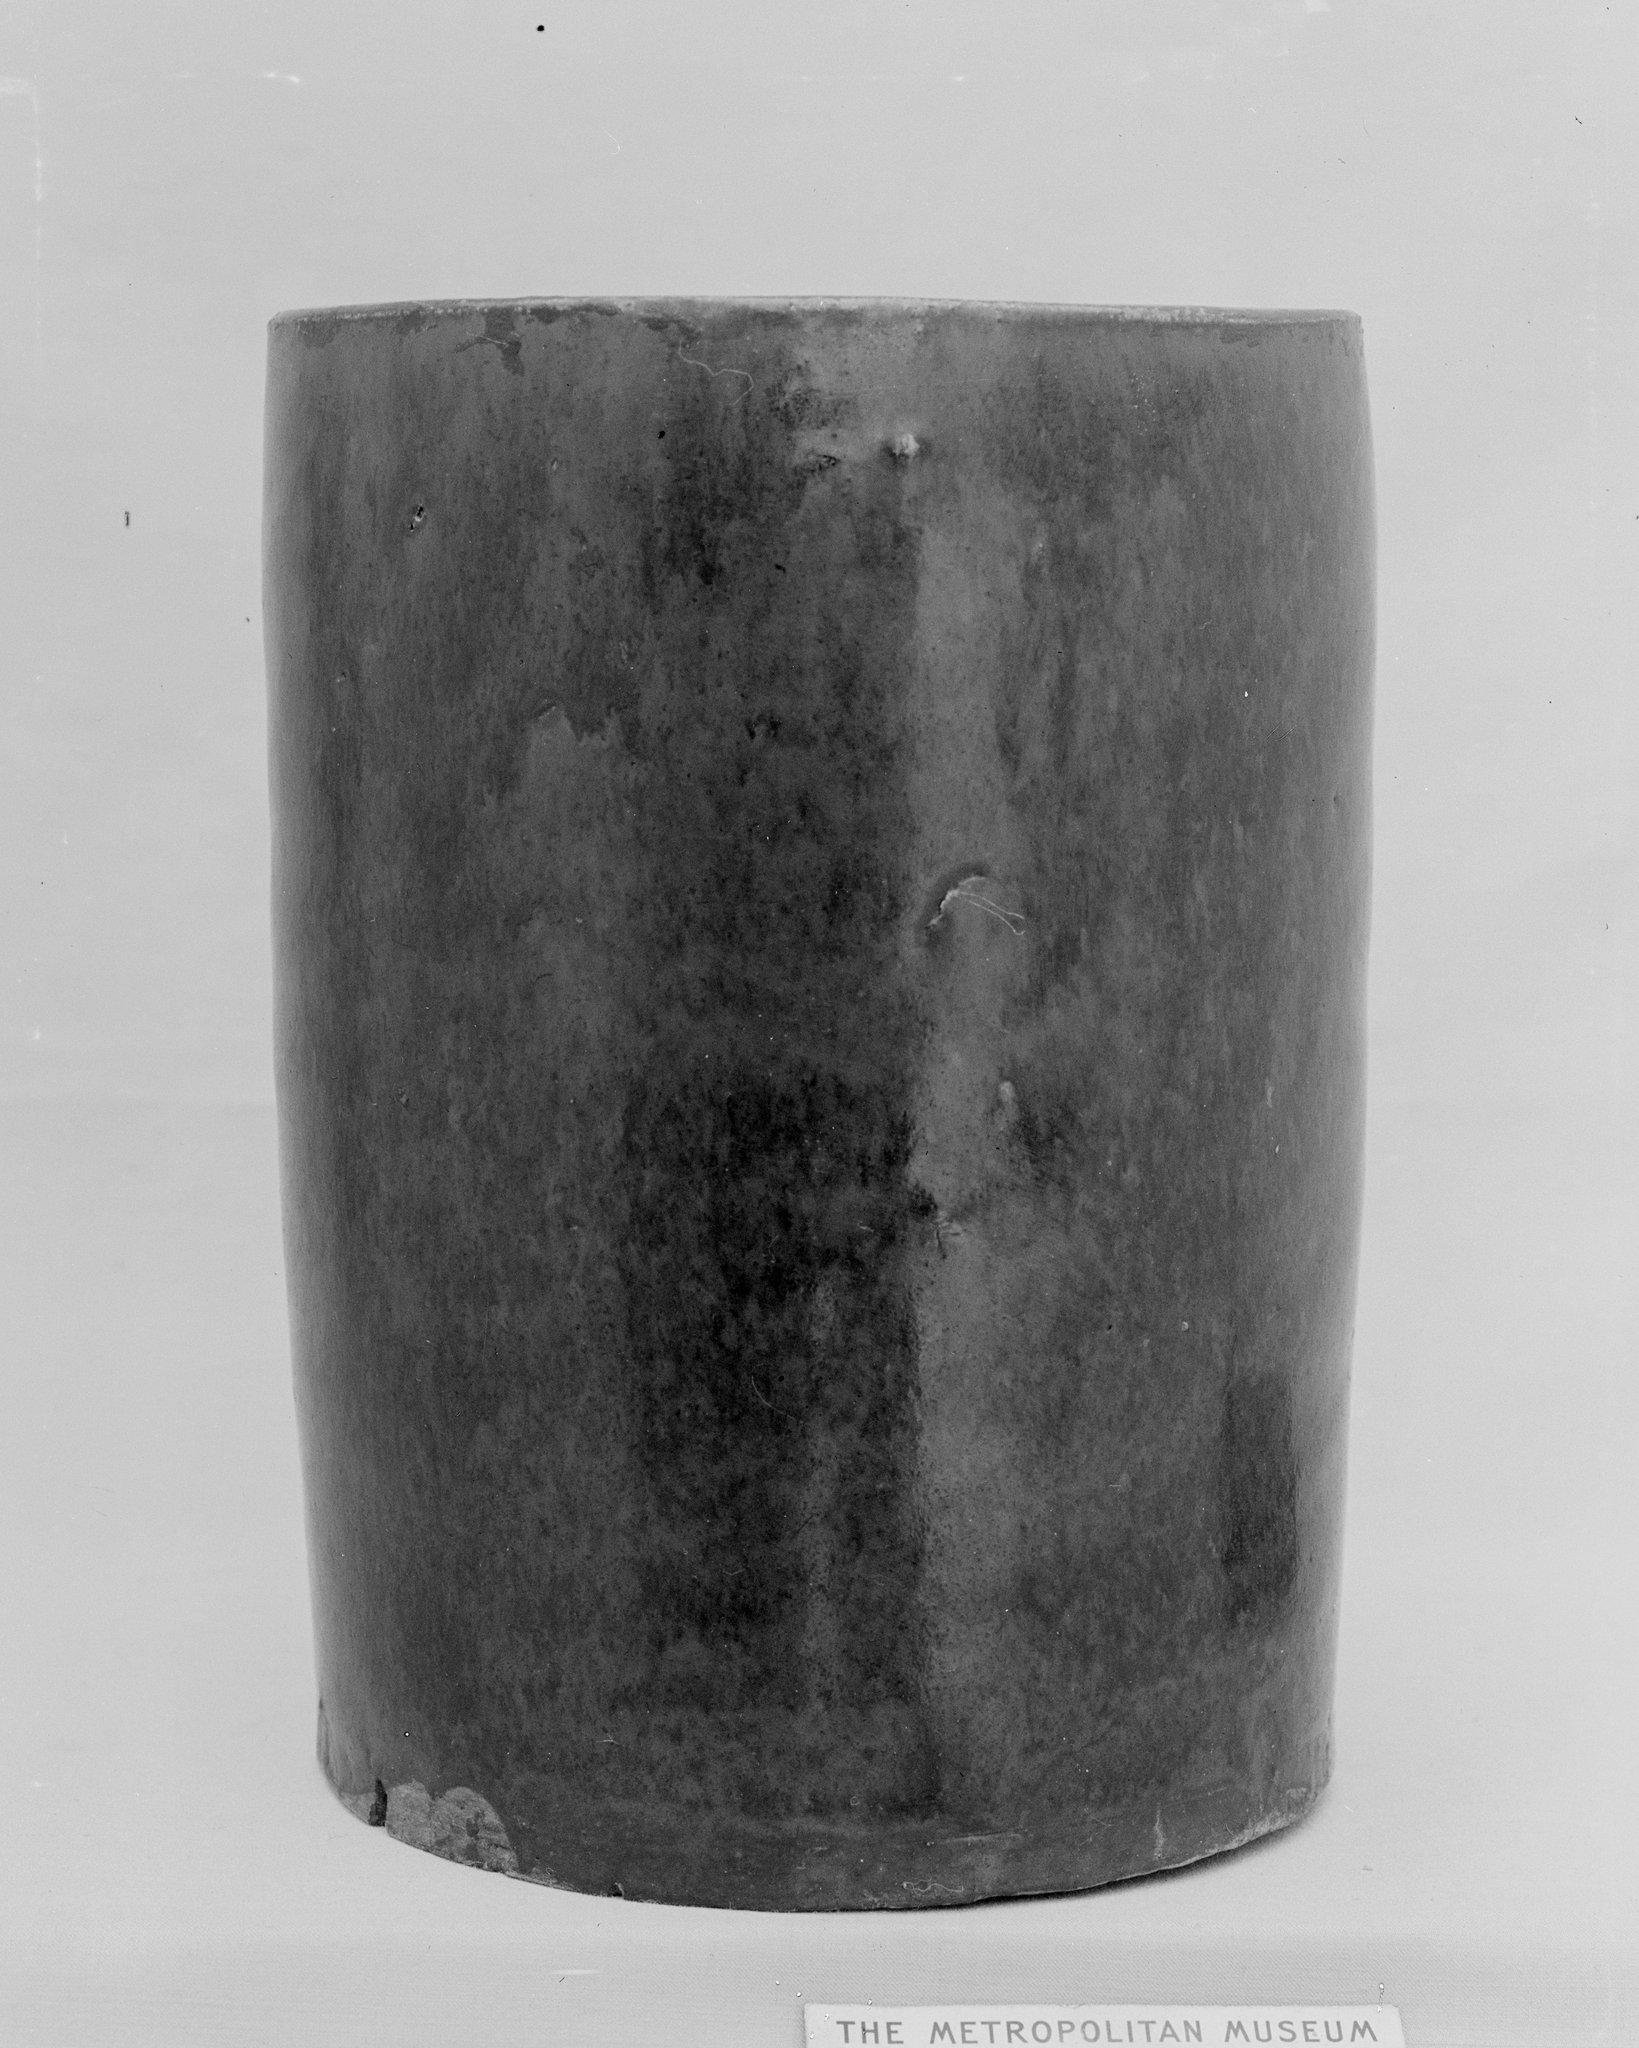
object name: water jar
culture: japanese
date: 1601-1700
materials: clay, glaze